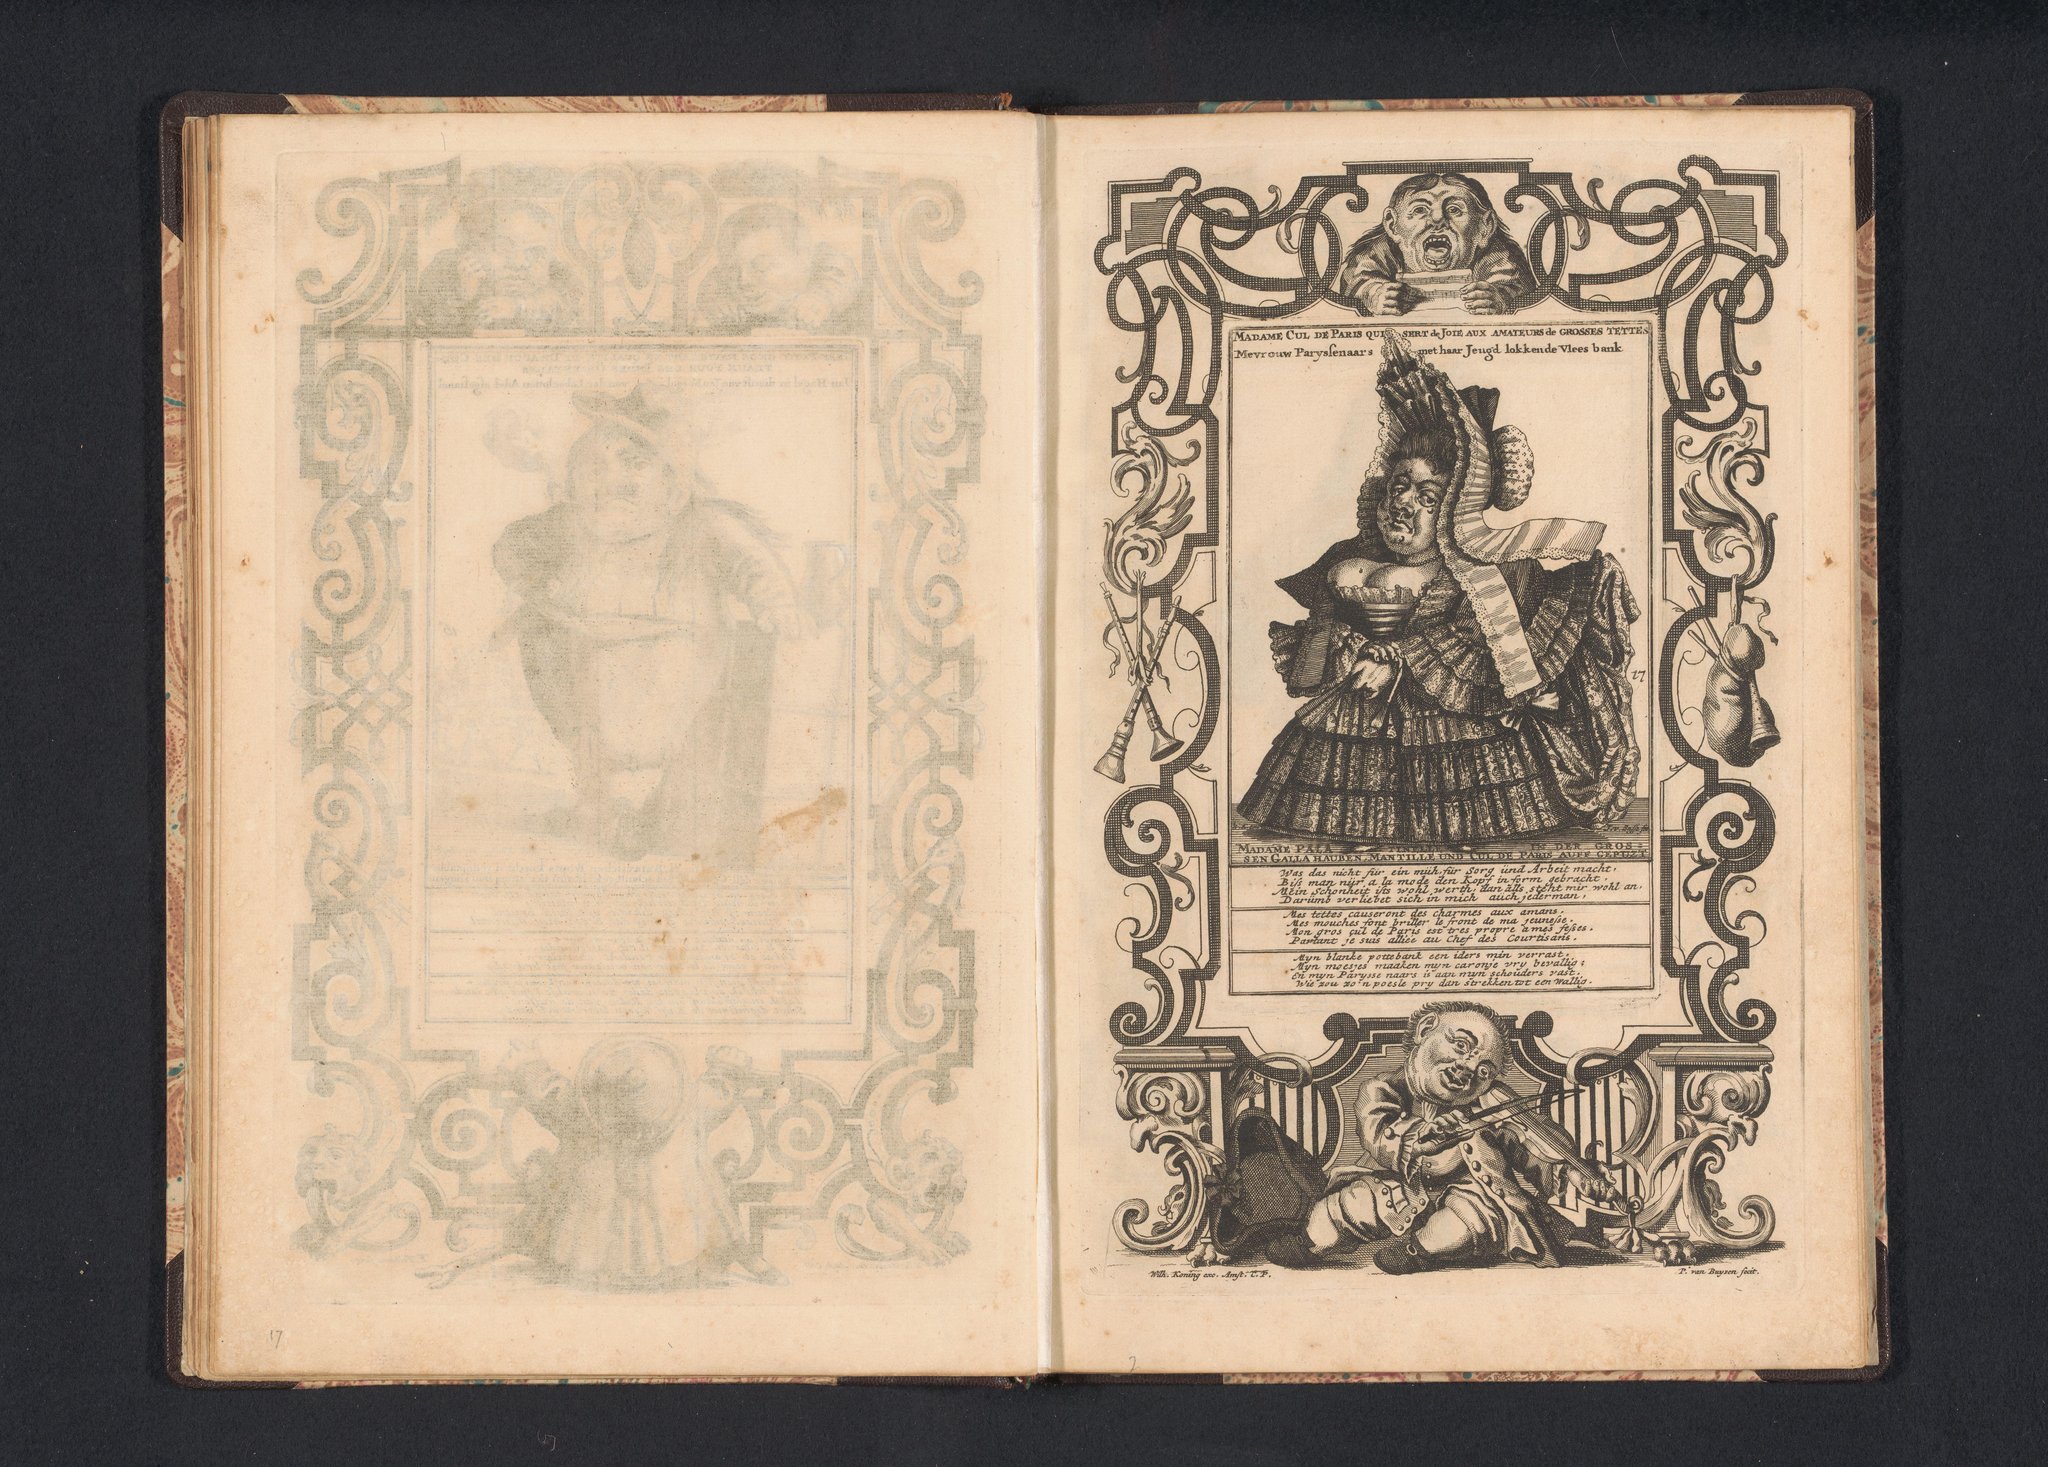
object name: caricature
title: Madame Cul de Paris qui sert de Joie aux amateurs de grosses tettes / Mevrouw Paryssenaars met haar Jeugd lokkende Vlees bank / Madame Palatinelle in der grossen Galla Hauben, Mantille und Cul de Paris auff geputzt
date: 1716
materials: paper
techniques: etching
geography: amsterdam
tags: violin, fiddle (+ artist at work), caricatures (human types), little people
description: De Franse kleine mens Mevrouw Paryssenaars, in gala. In het onderschrift verzen in het Duits, Frans en Nederlands. Afdruk binnen een decoratieve omlijsting gedrukt van een aparte plaat met onderaan een kleine mens die viool speelt. Genummerd rechts midden: 17. Onderdeel van de Nederlandse gebonden uitgave uit 1716 van een serie karikaturen van kleine mensen, bekend als Het Dwergentooneel, gekopieerd naar een ouder Duits voorbeeld.